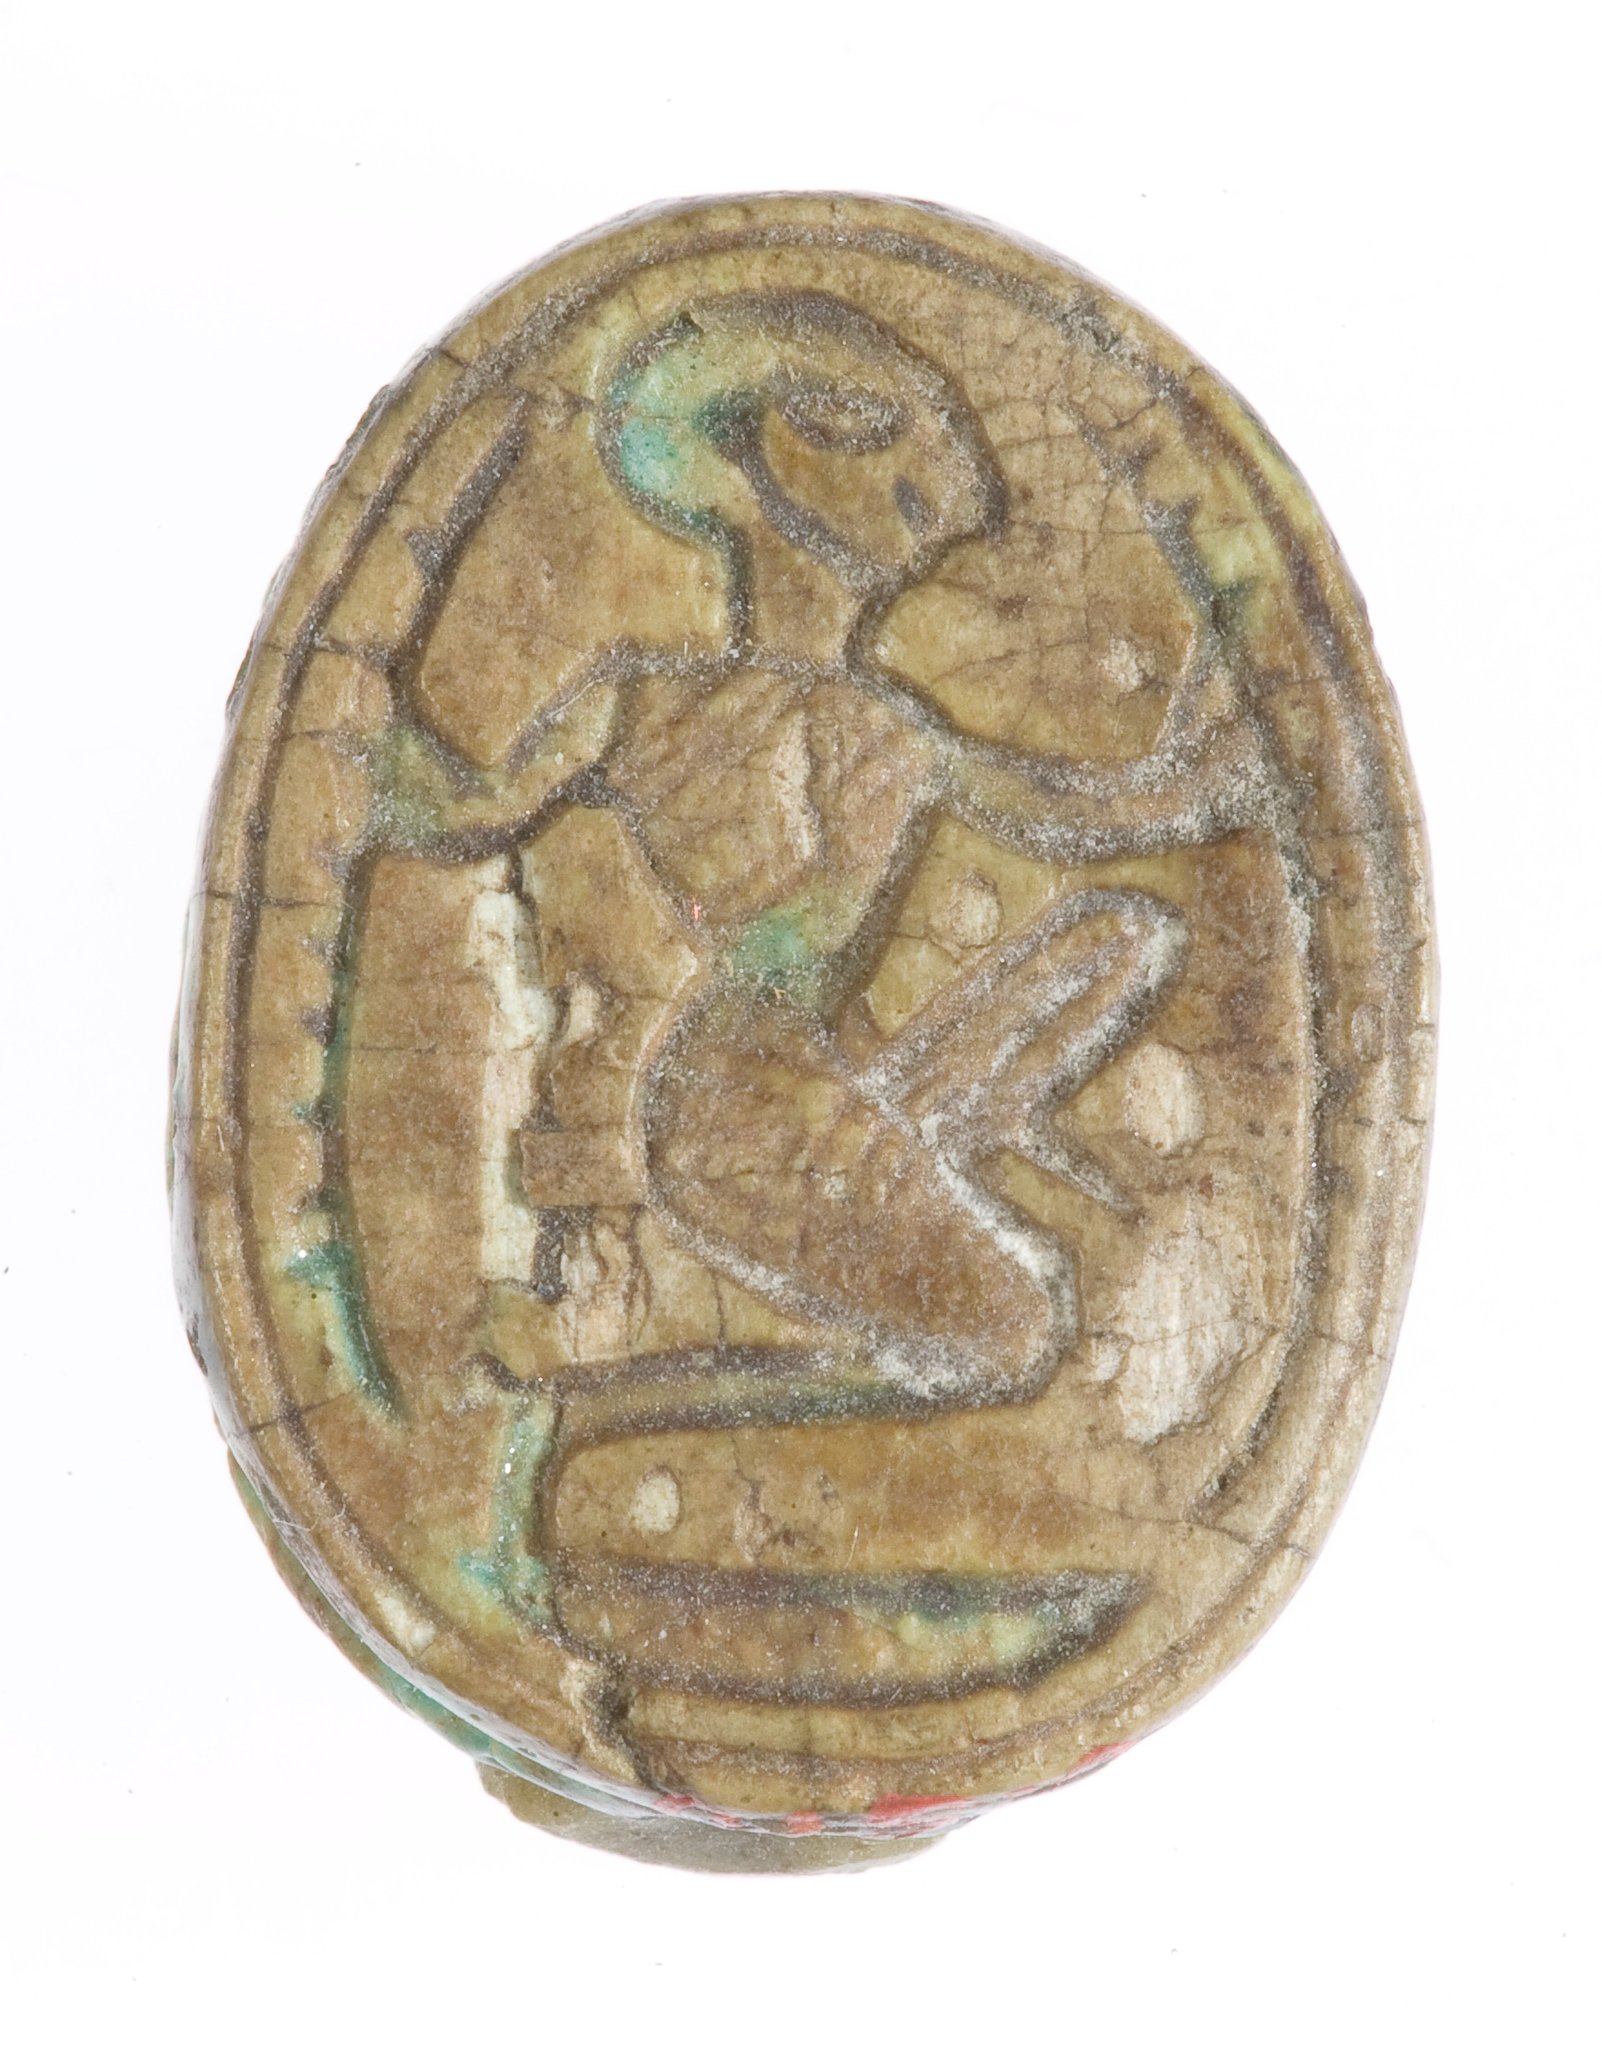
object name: scarab, kneeling king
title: Scarab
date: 1550-1458 BCE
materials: stone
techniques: glazing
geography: egypt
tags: scarabs